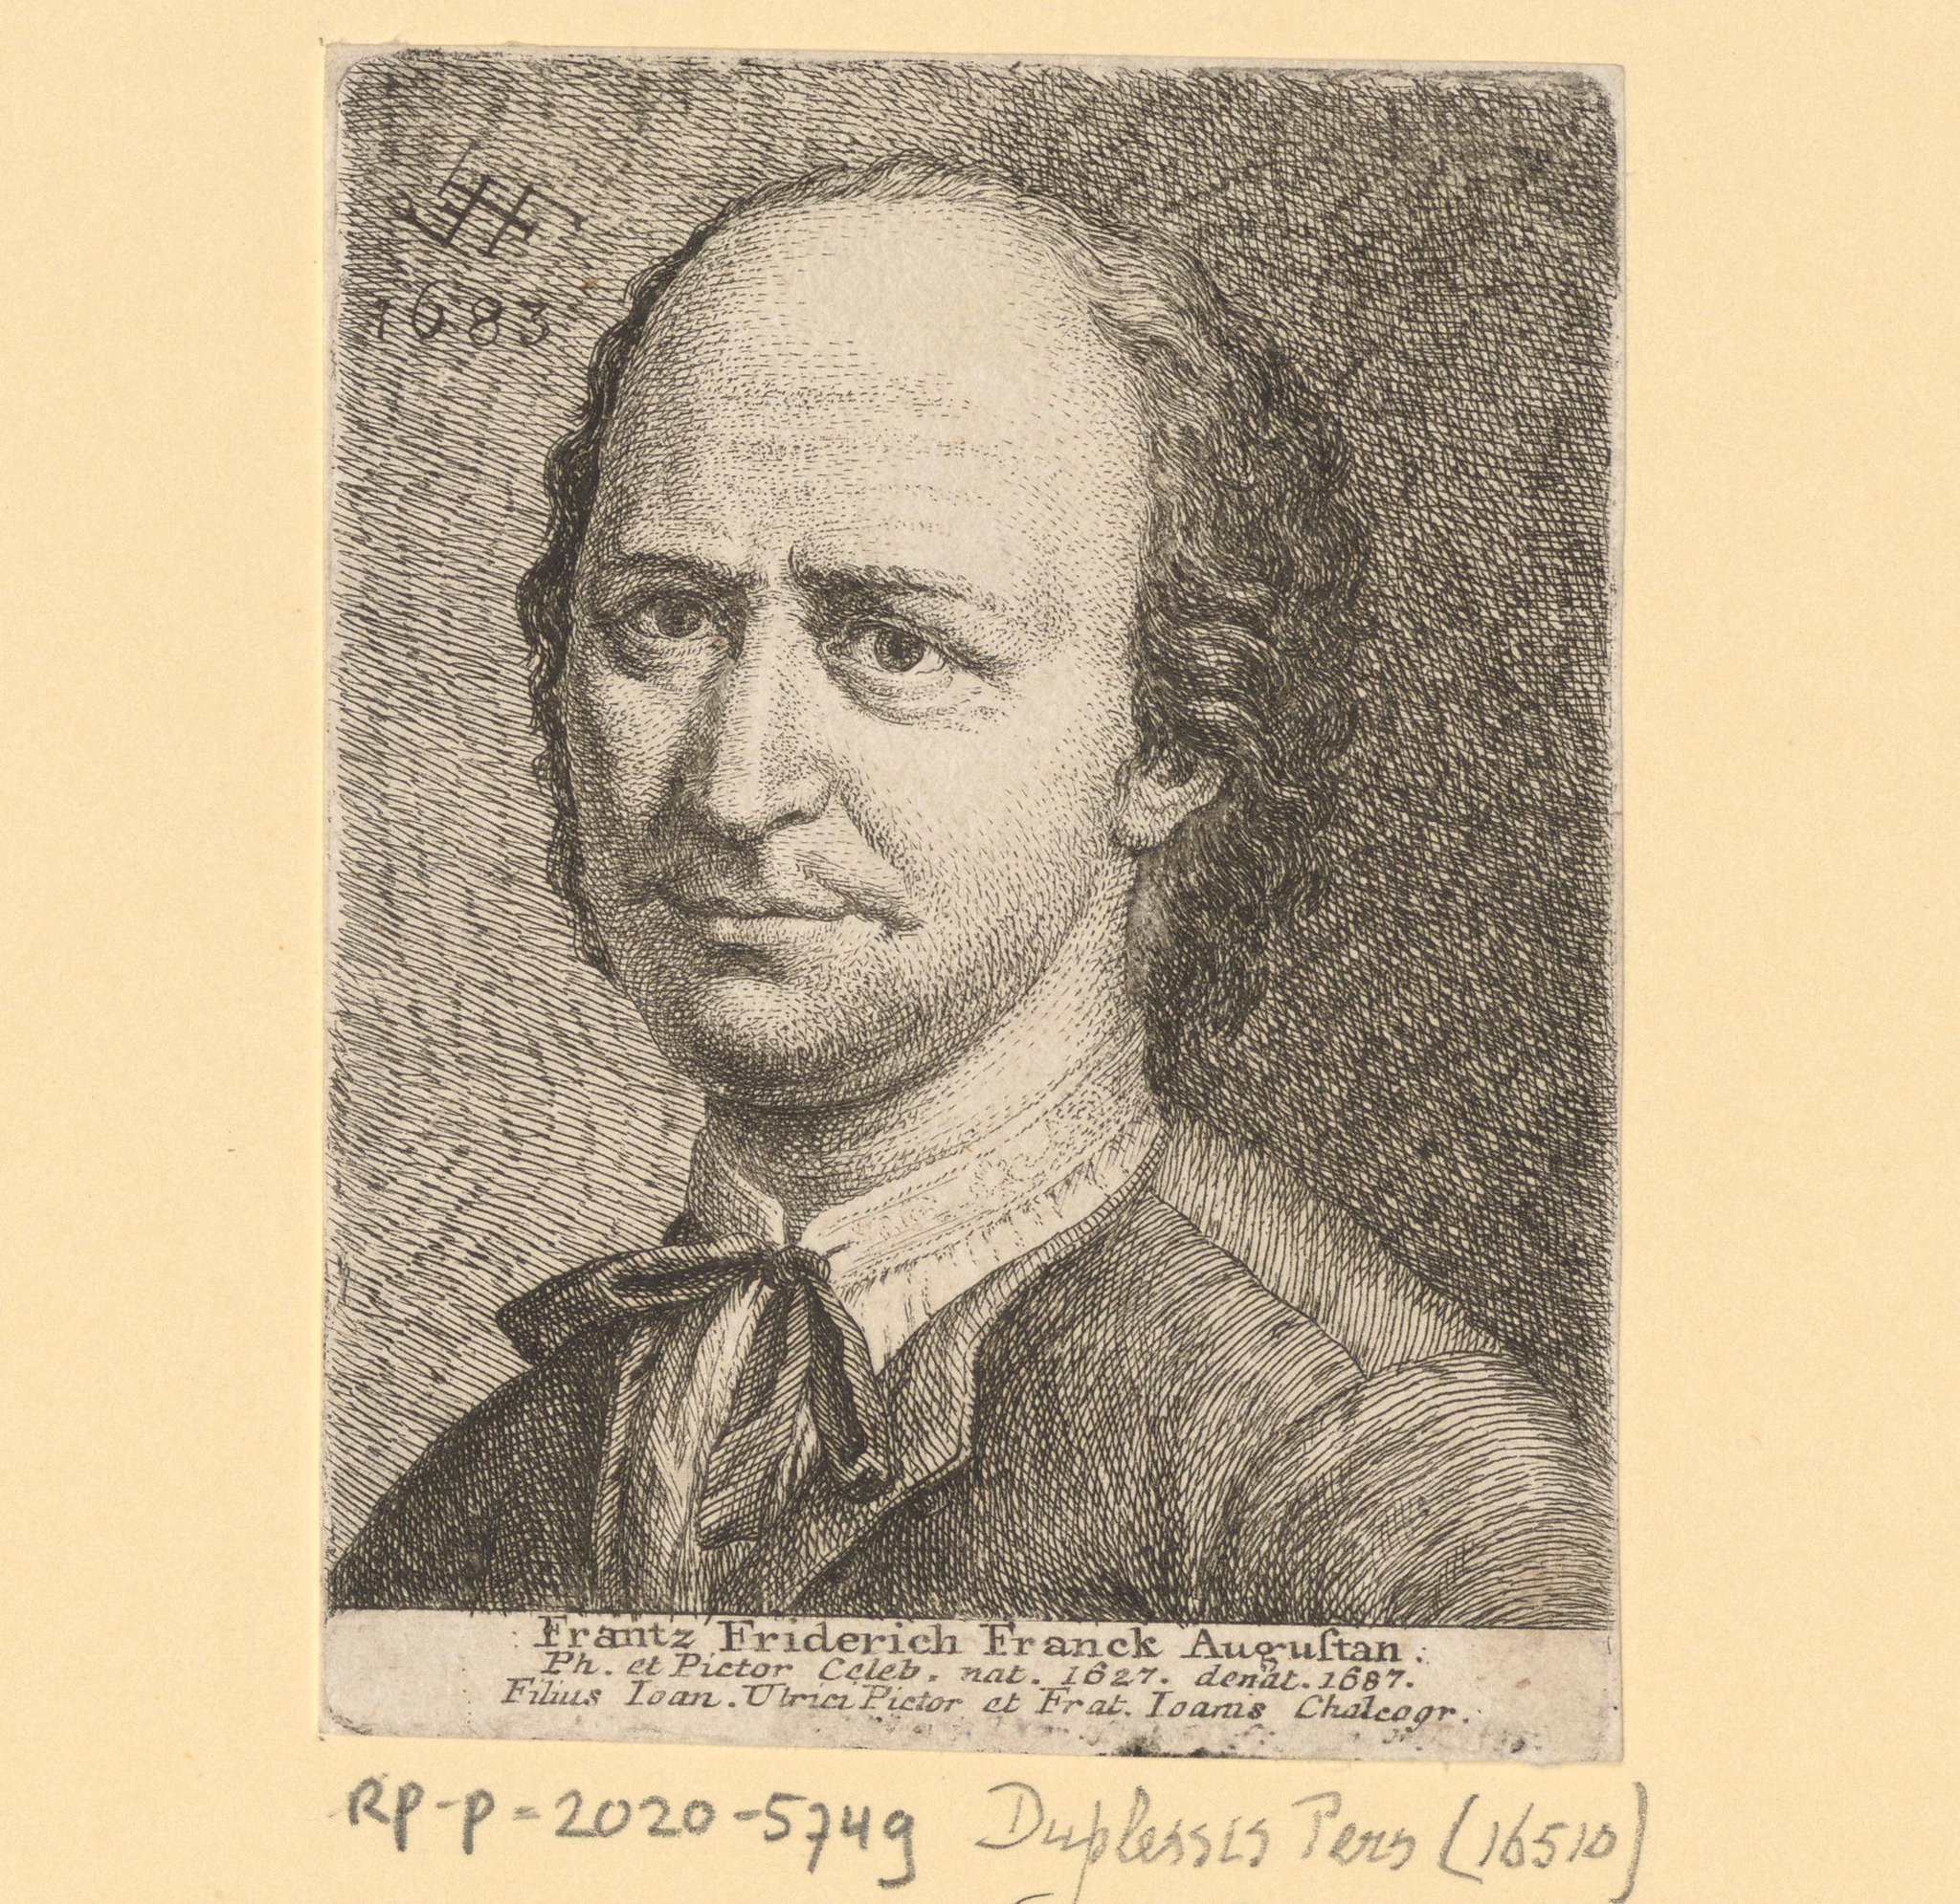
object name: print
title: Portret van Franz Friedrich Franck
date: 1766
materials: paper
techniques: engraving, etching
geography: augsburg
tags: painter, artist, franz friedrich franck, historical persons, portrait, self-portrait of painter